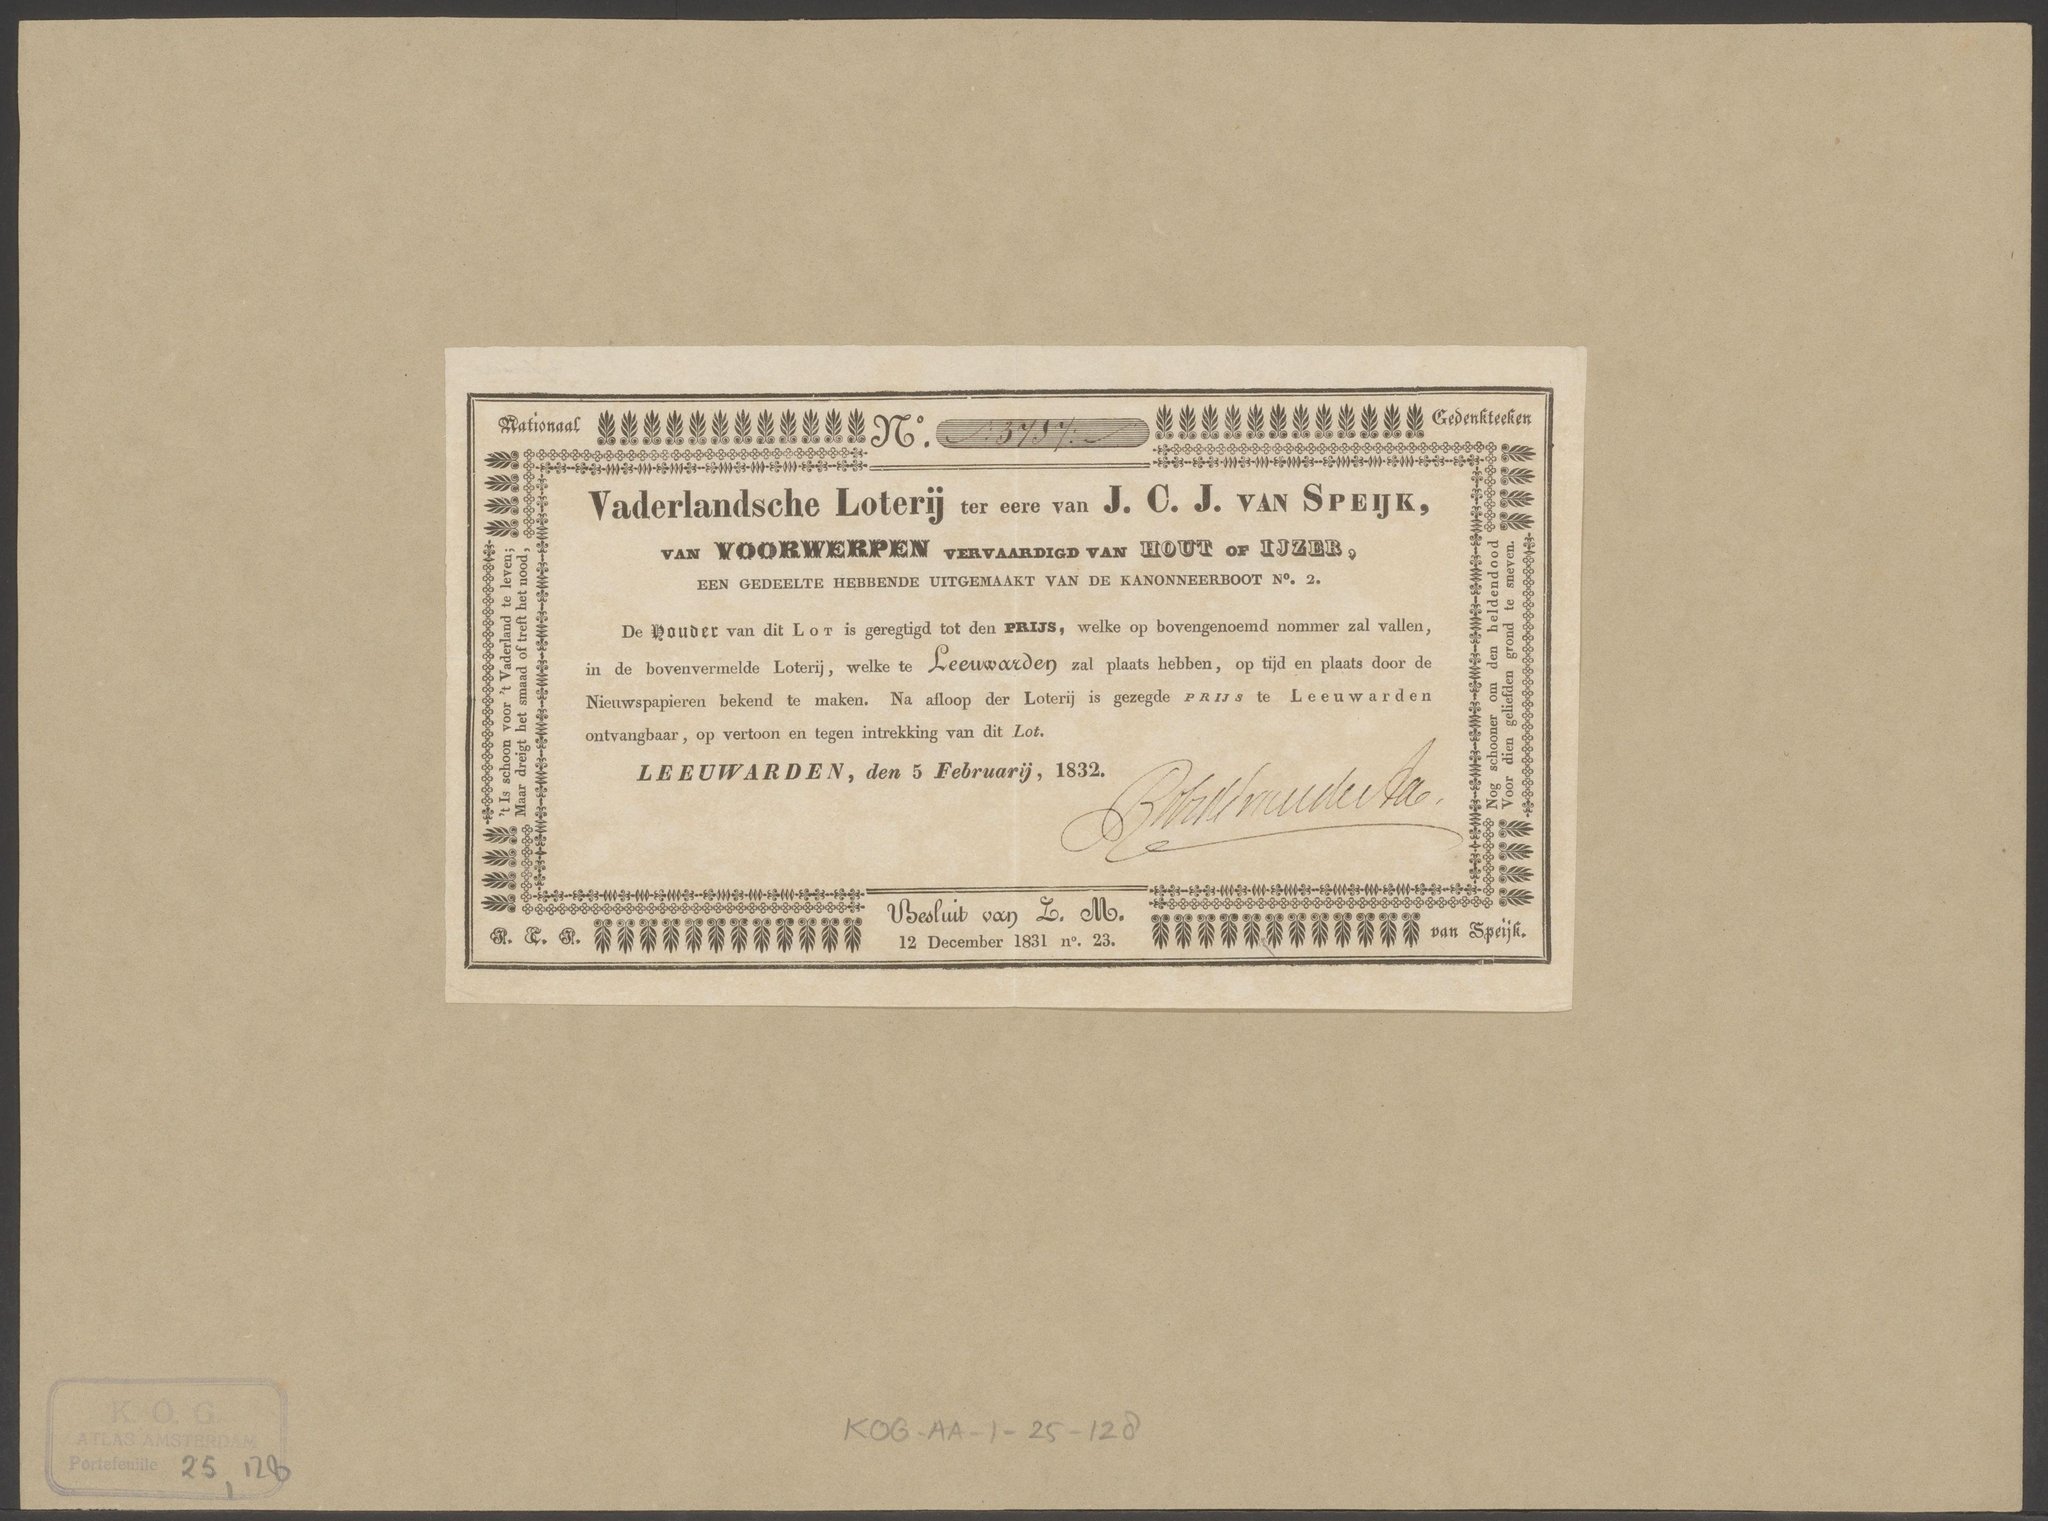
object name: print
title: Vaderlandsche Loterij ter eere van J.C.J. van Speyk, van voorwerpen vervaardigd van hout of ijzer, een gedeelte hebbende uitgemaakt van de kanonneerboot No. 2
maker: Anonymous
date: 1832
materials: paper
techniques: letterpress printing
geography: netherlands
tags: amsterdam, antwerp, jan van speyk, raffle, lottery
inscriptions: signature: ‘R[...]a’, collector's mark: ‘25.128’ Lugt 1641b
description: Onderwerpsrubriek binnen de Atlas Amsterdam: Krijgswezen I: De Admiraliteit van Amsterdam, D. J.C. van Speyk.